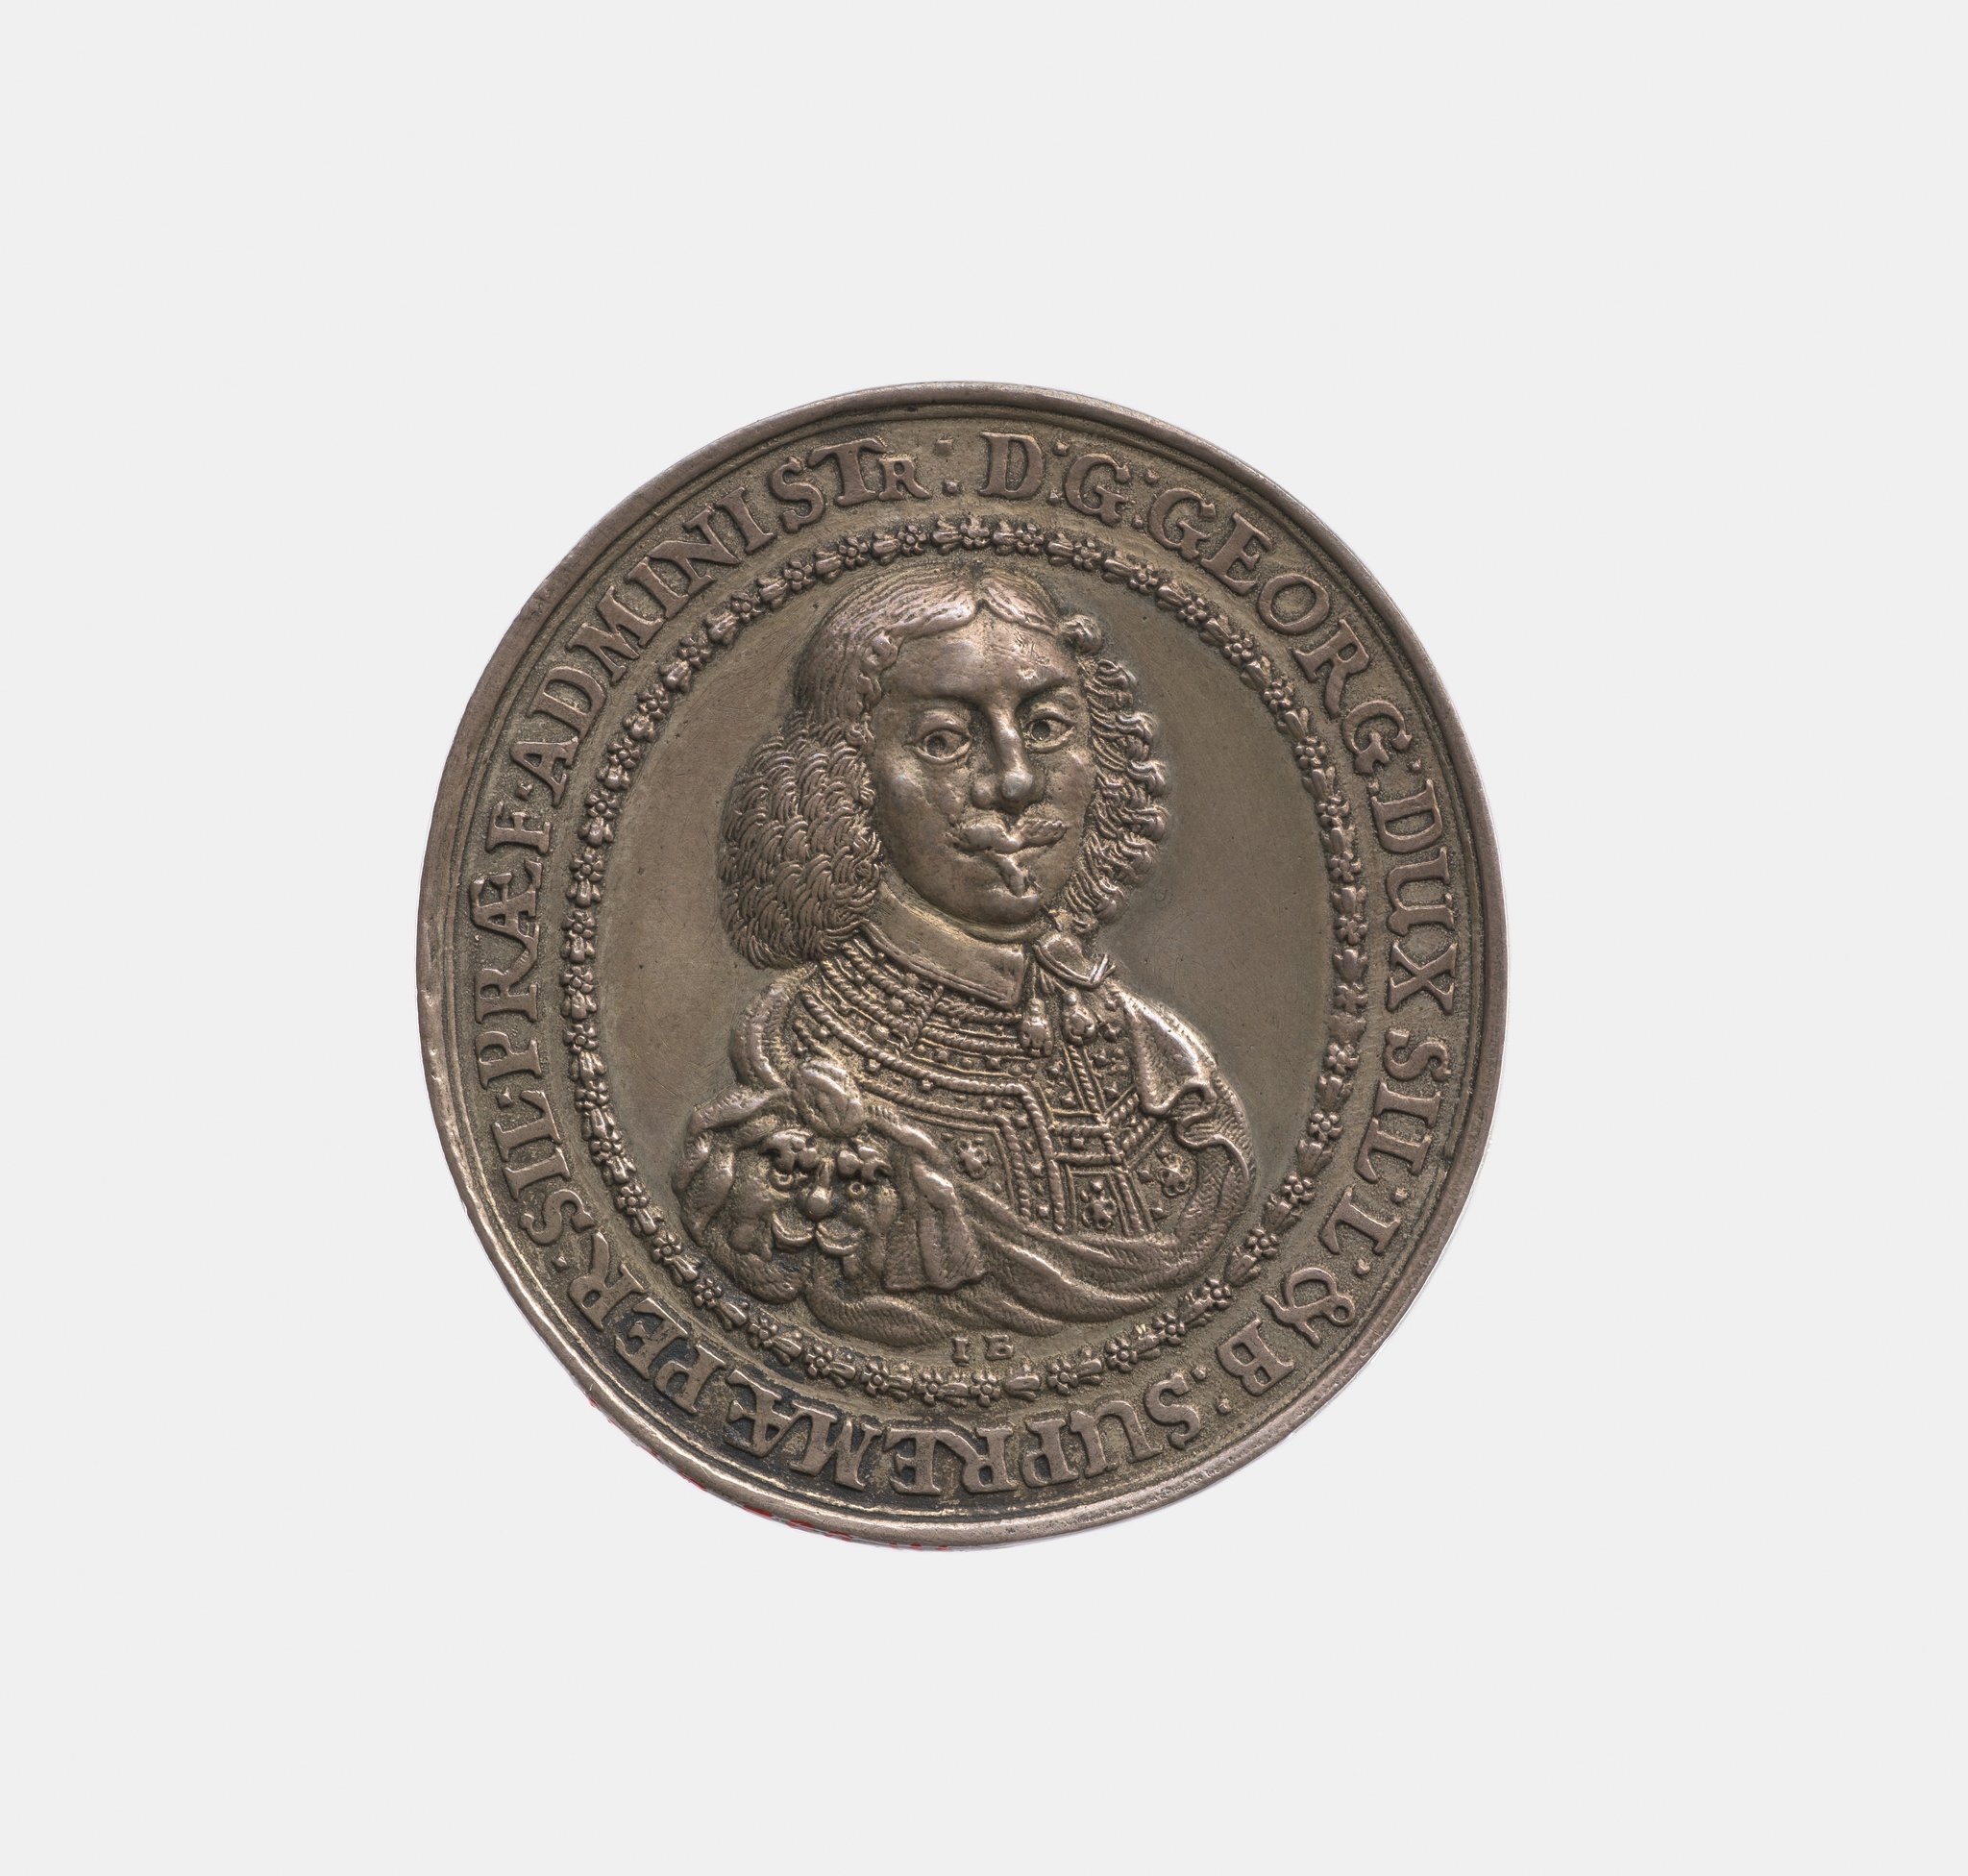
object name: medal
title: George III Duke of Silesia, Liegnitz, and Brieg 1639-64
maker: johann buchheim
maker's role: artist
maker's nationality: german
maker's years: 1624-1683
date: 1624-1683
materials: silver